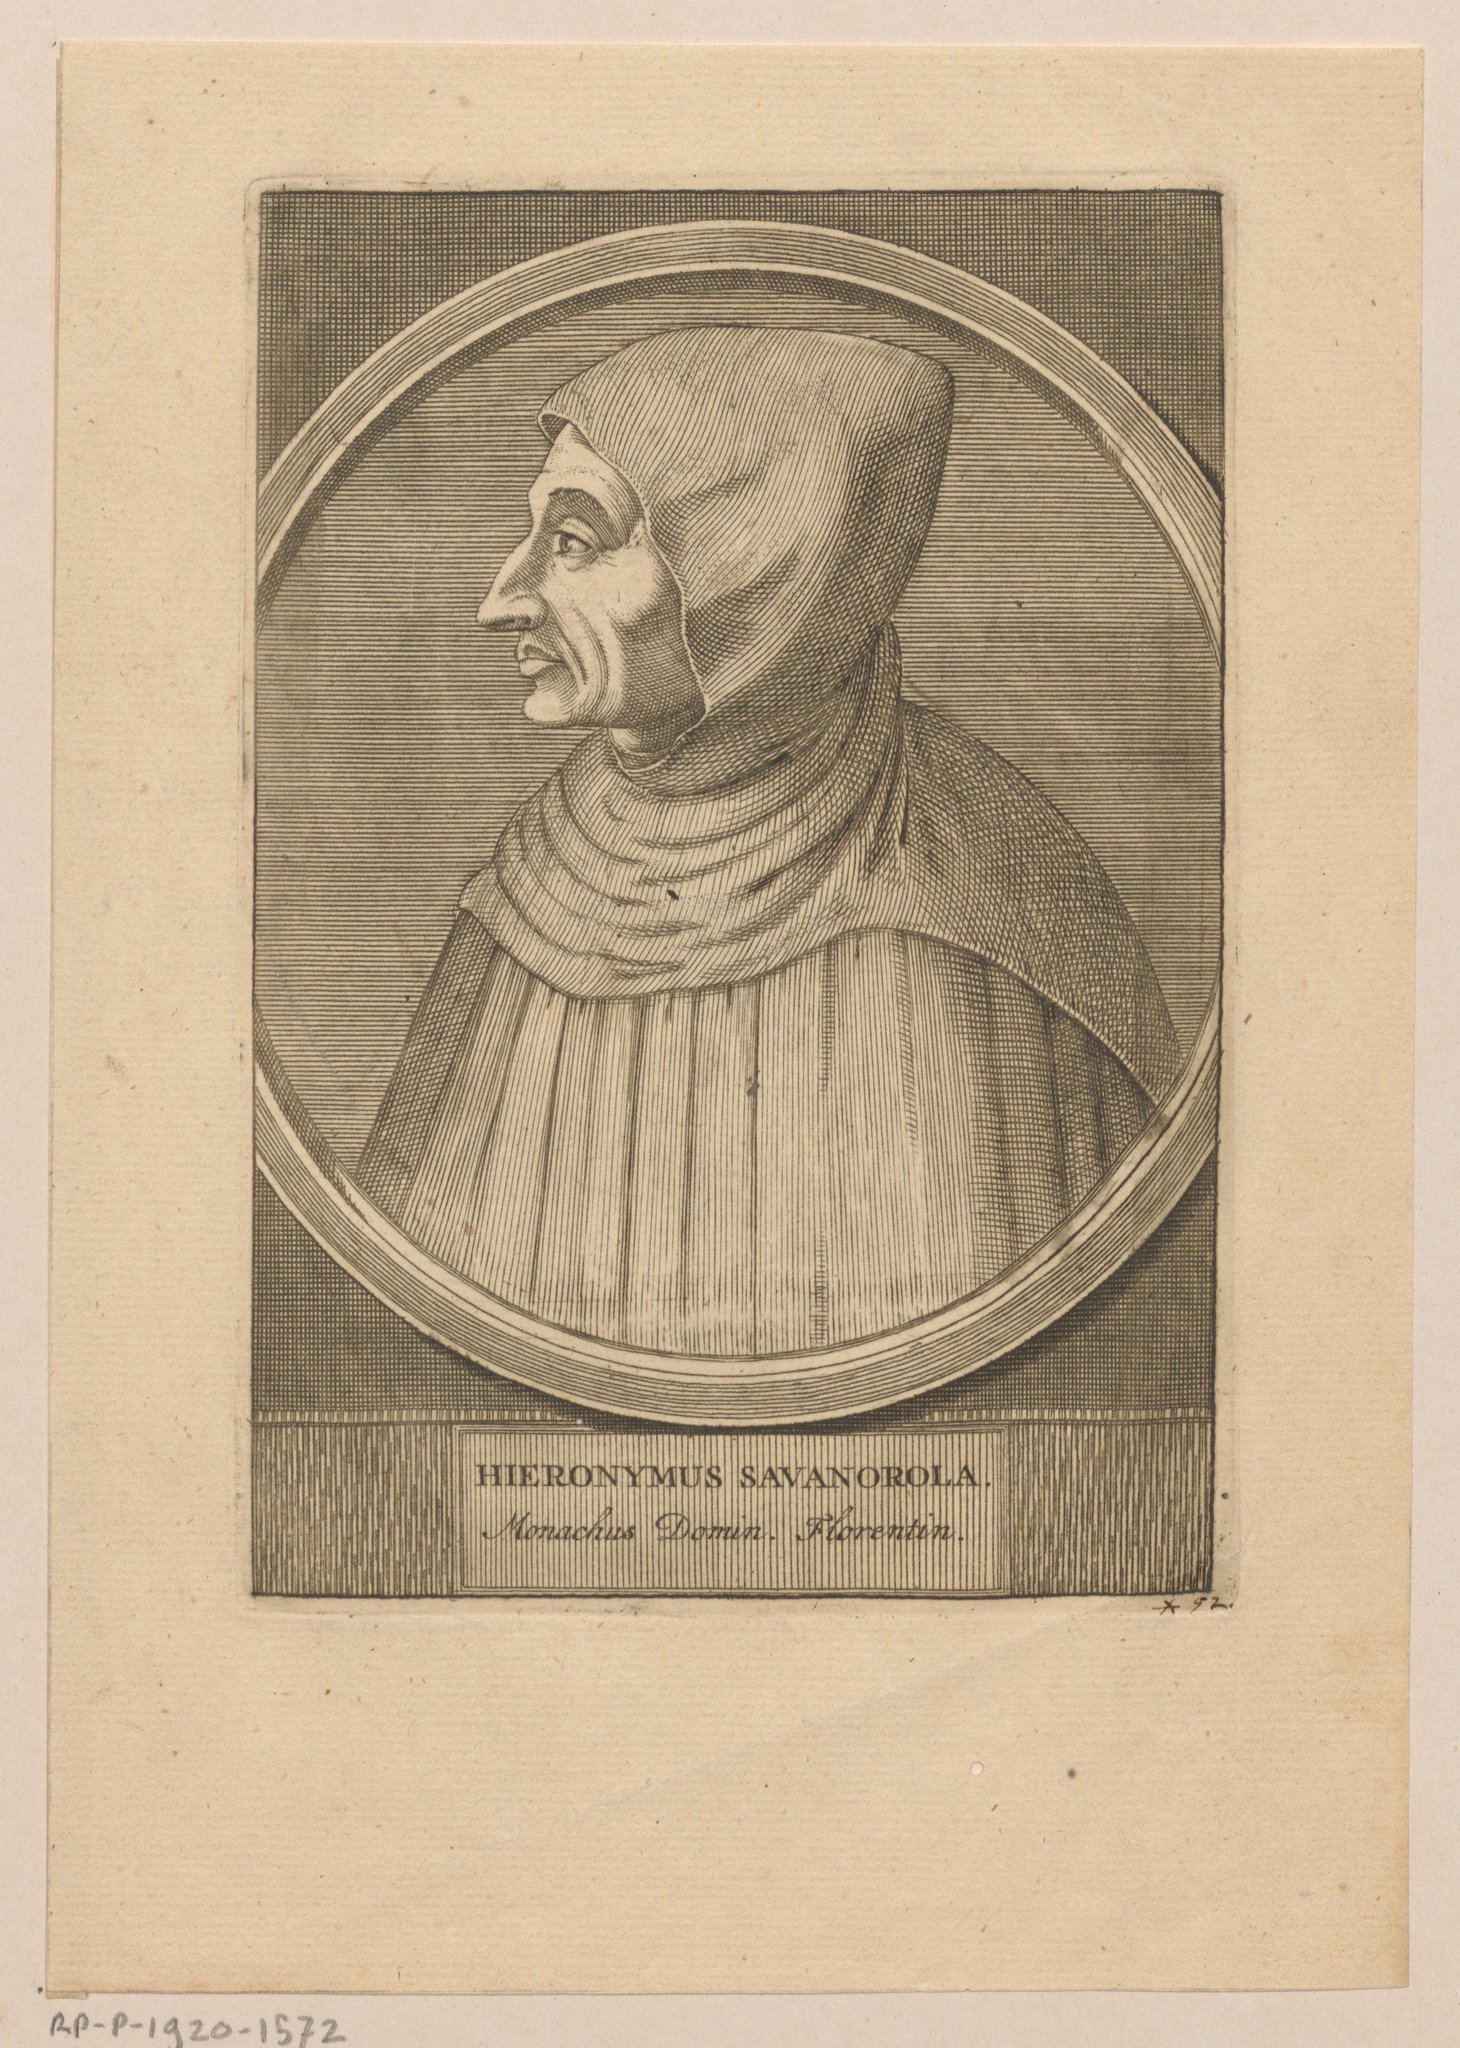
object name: print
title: Protestantse hervormers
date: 1690-1729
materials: paper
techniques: engraving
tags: priest, politician, theologian, historical persons, monastic orders, monastic life: dominicans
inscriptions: inscription: ‘*92’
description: Prent waarschijnlijk uit: Le miroir des portraits des premiers reformateurs des églises protestantes. Leiden: Pieter van der Aa, [1690-1729]. Eerdere staat gebruikt in serie uit 1599 en publicaties uit 1602 en 1604.